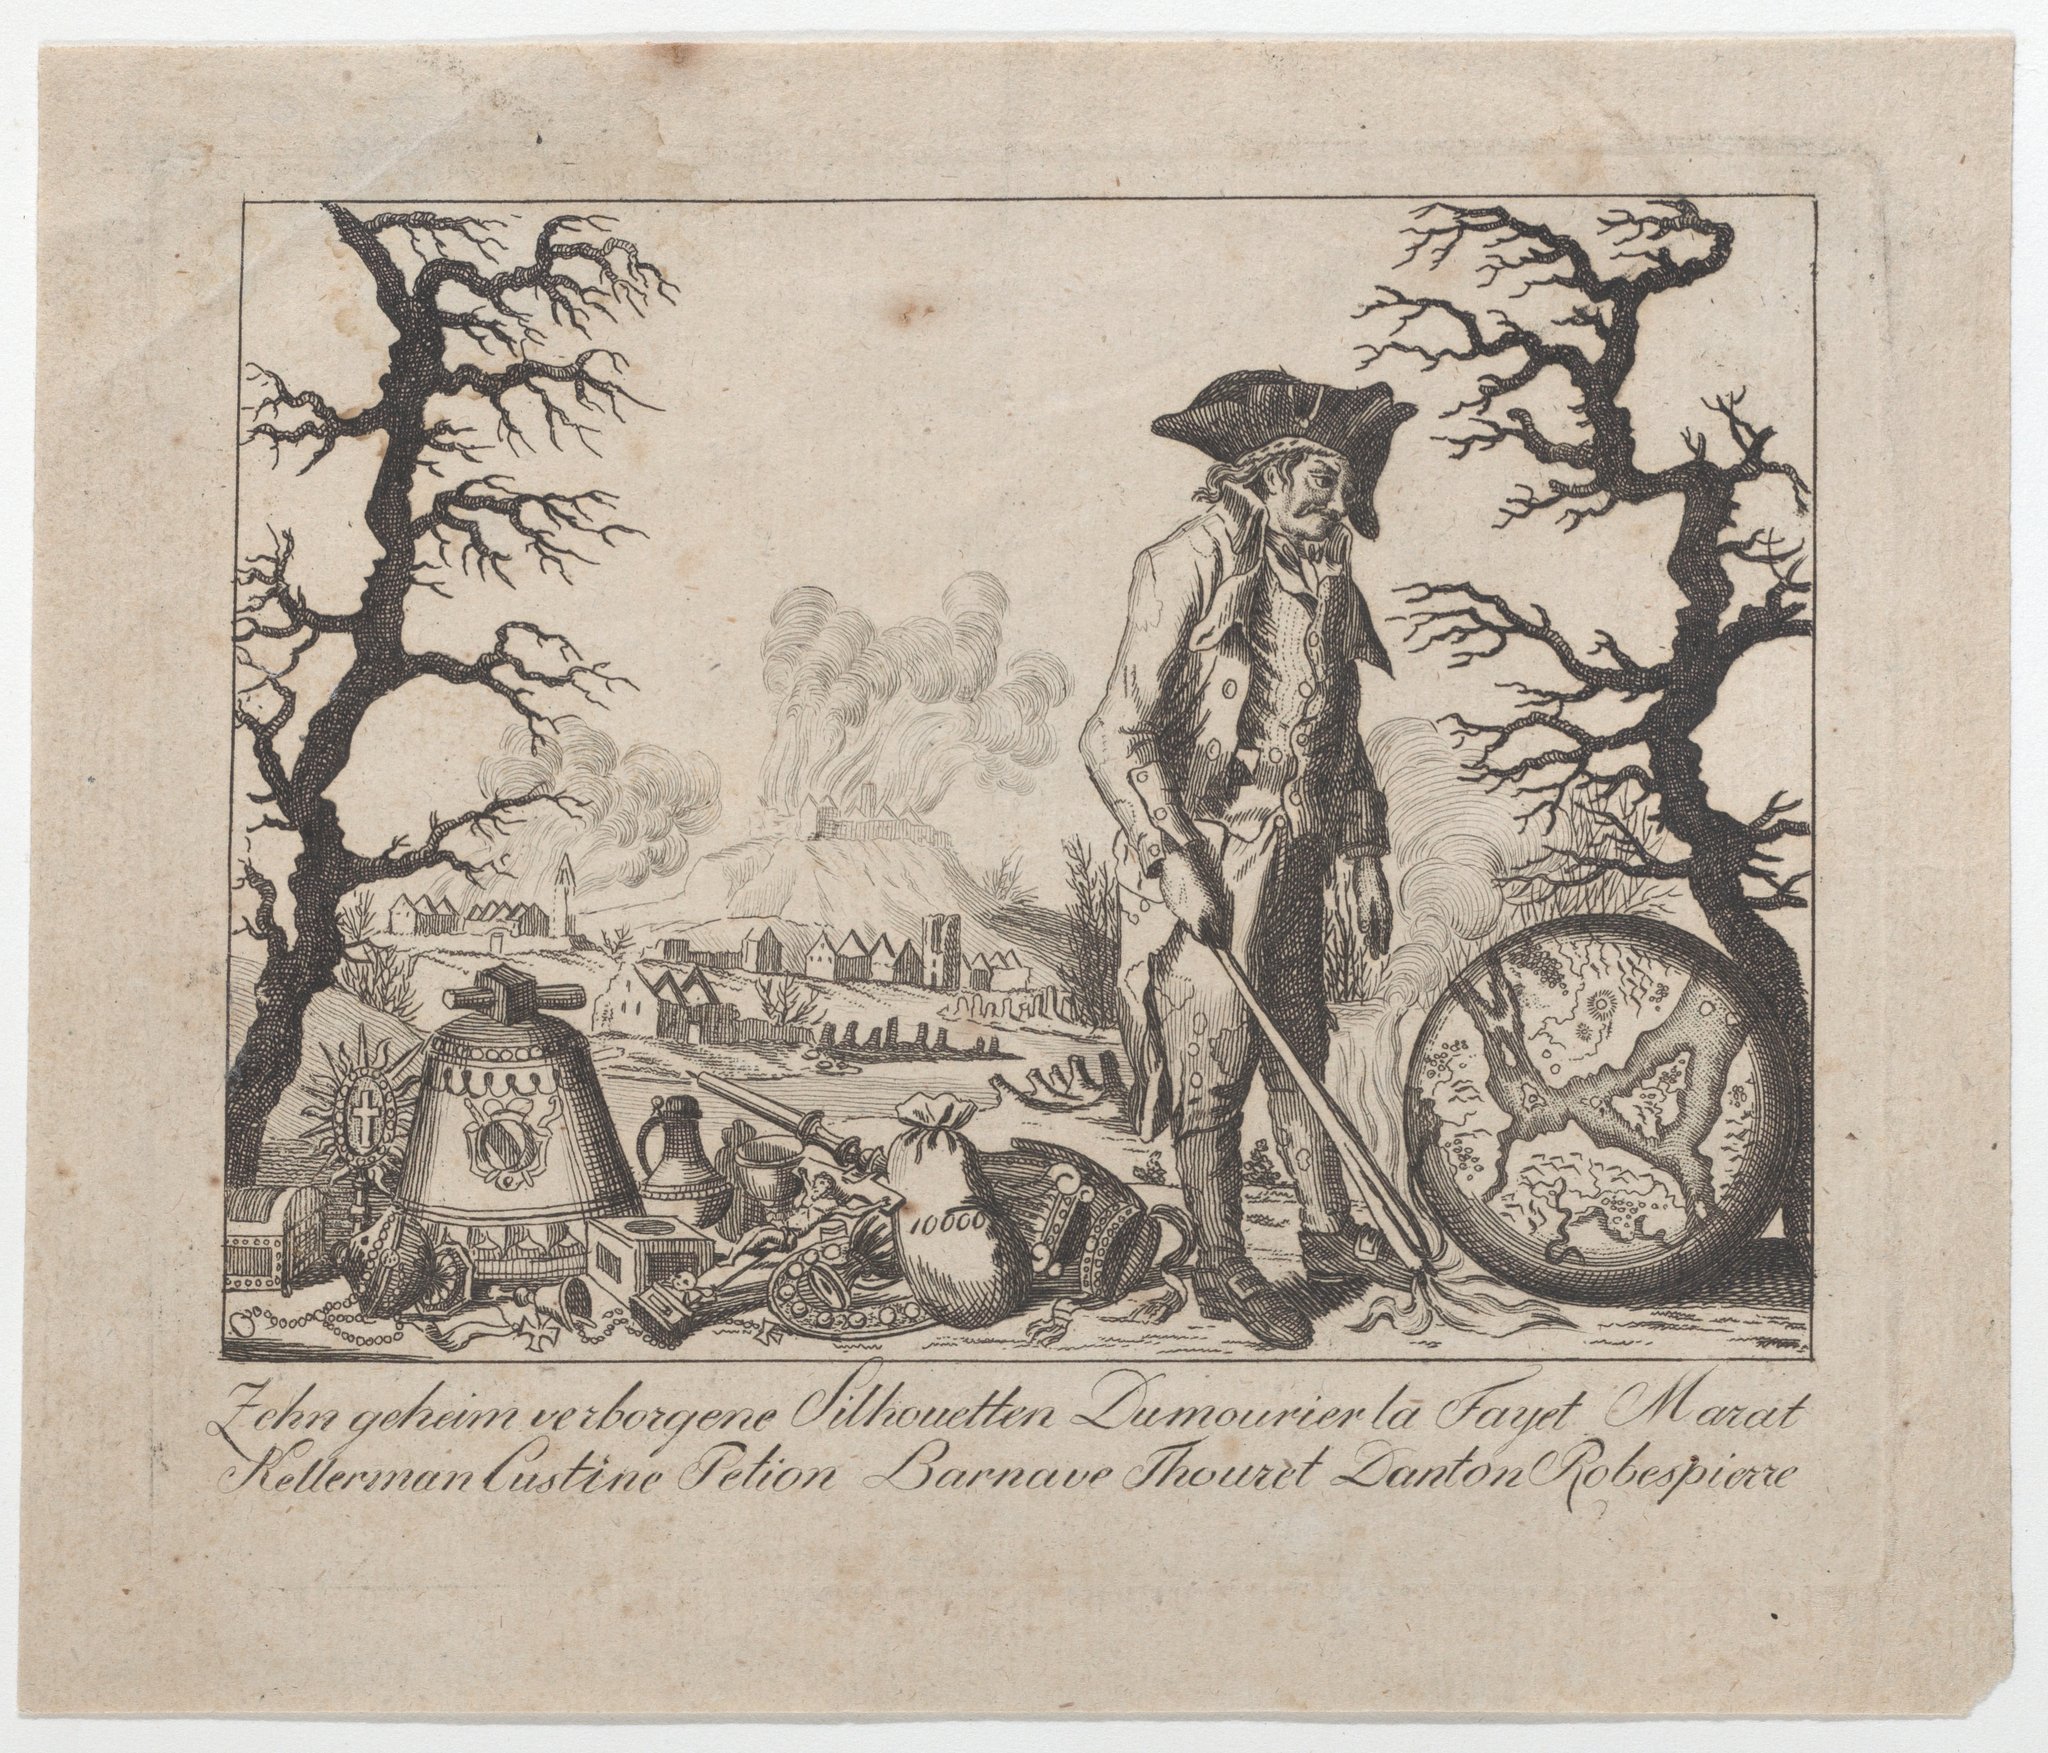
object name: print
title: Caricature and hidden silhouette representations of Lafayette and others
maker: Anonymous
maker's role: artist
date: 1701-1800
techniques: etching